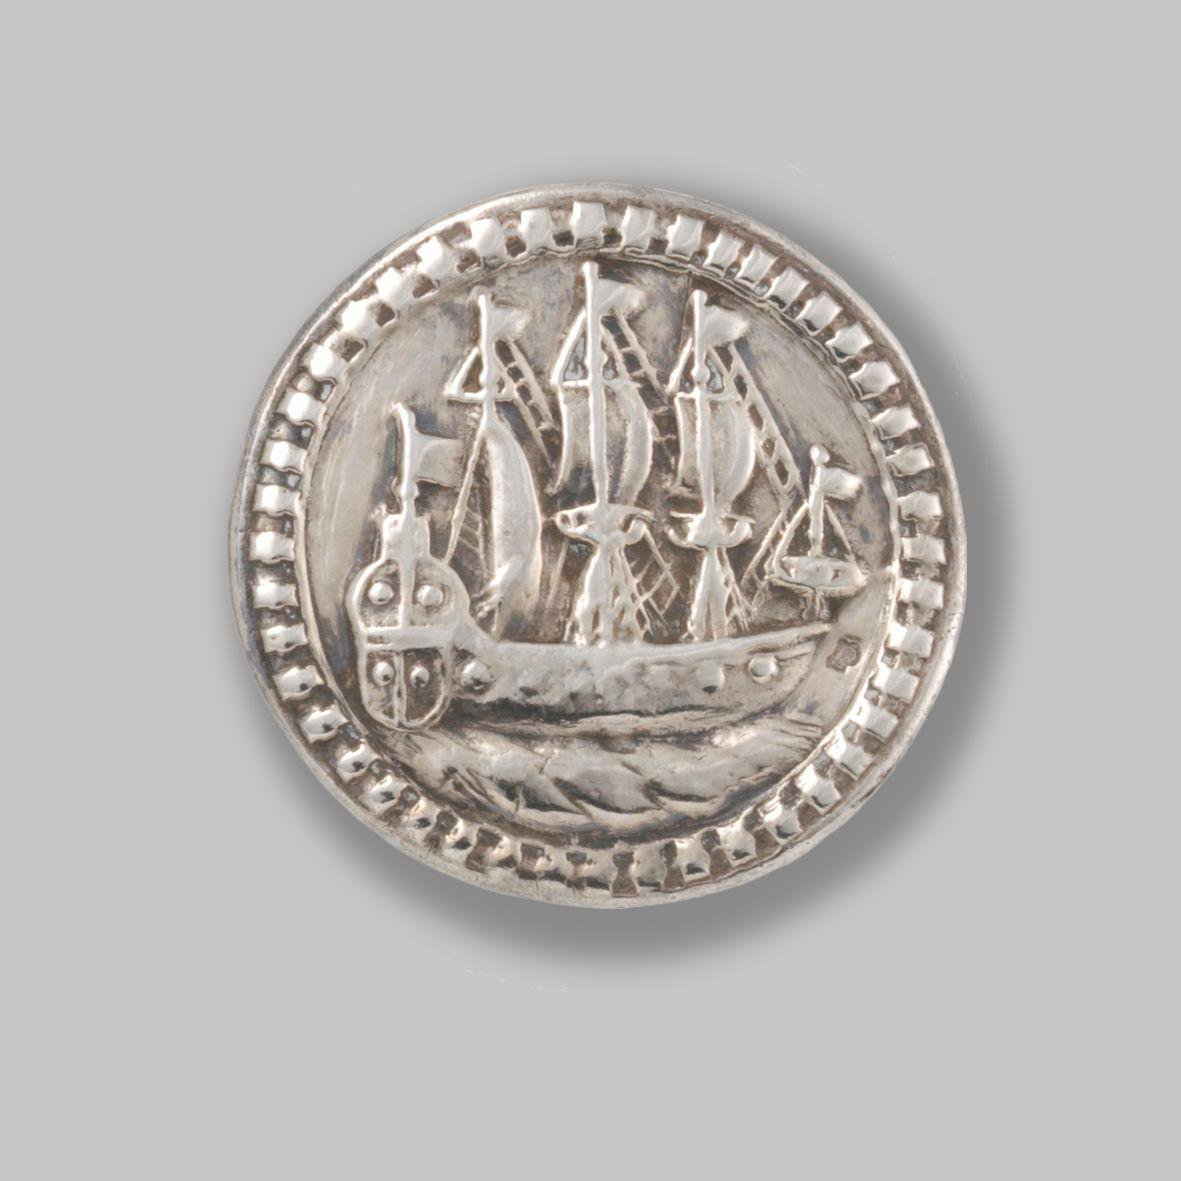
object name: button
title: Knoop met voorstelling van een driemaster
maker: Anonymous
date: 1850-1900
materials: silver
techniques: casting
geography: netherlands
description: Knoop van gegoten zilver, rond, met op de voorzijde een driemaster omgeven door een parelrand. Aan de achterzijde is een uit gebogen draad vervaardigd oog bevestigd. Op de achterzijde gemerkt: H en nog twee merken.